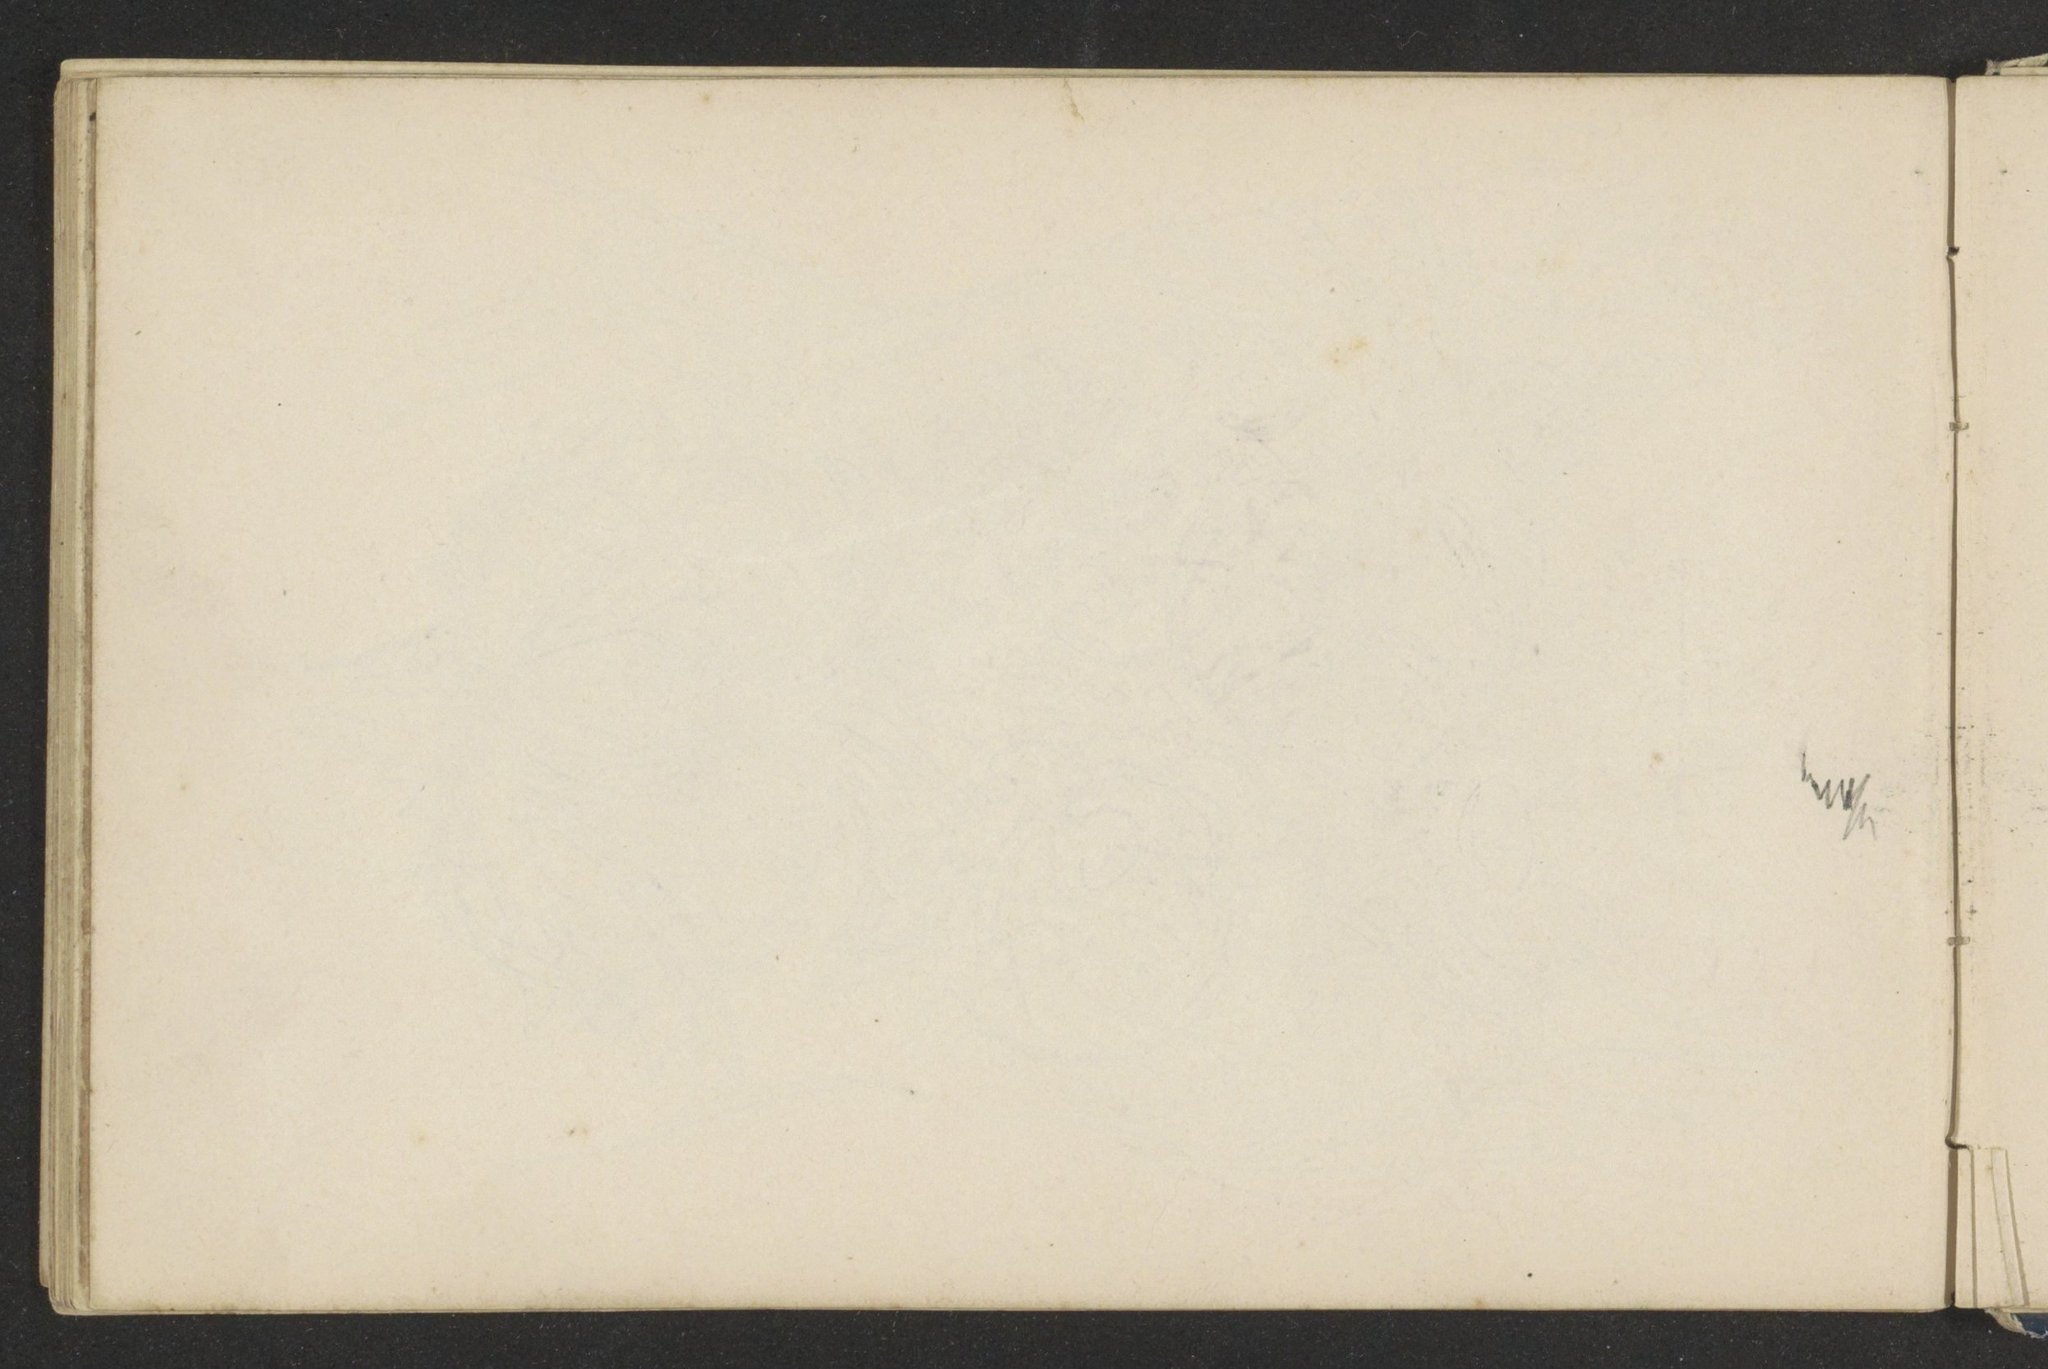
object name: sketchbook leaf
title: Studie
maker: Anonymous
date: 1841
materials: paper, pencil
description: Blad 23 verso uit een schetsboek met 33 bladen.